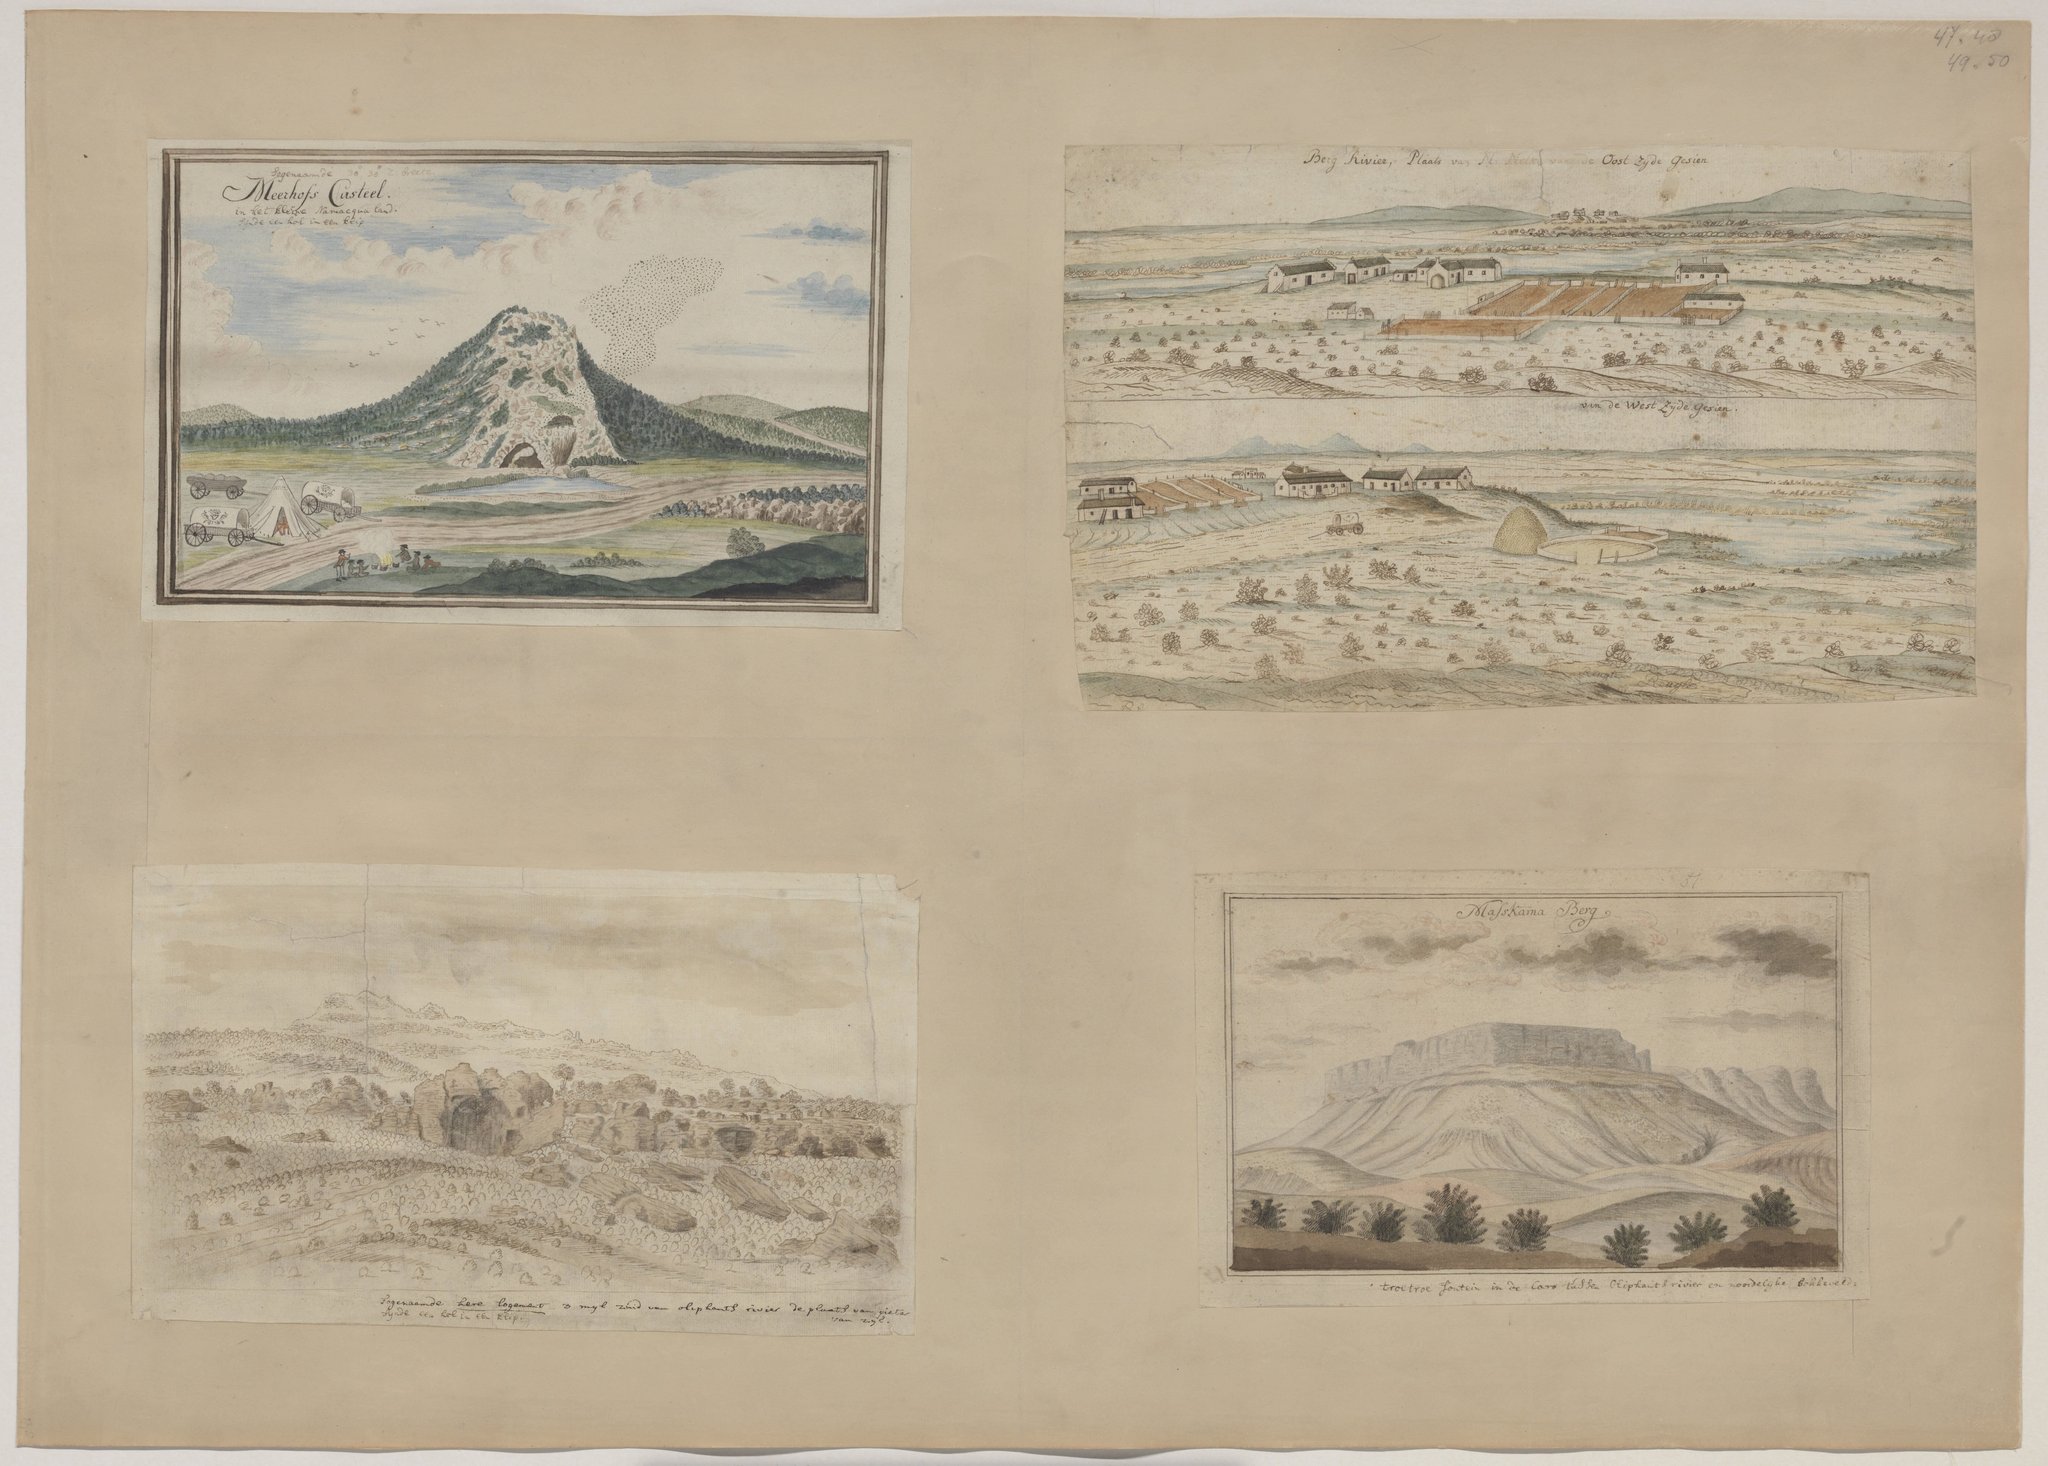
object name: drawing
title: The “Heerenlogement”, a rock formation on the farm of Pieter van Zyl to the west of the confluence of the Doorn- and Olifants- rivers.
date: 1779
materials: ink, paper, pencil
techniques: brush, pen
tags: farm or solitary house in landscape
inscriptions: annotation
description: Het "Heerenlogement", een rotsformatie op de boerderij van Pieter van Zyl, westelijk van en nabij de samenvloeiing van Doorn- en Olifantsrivier.